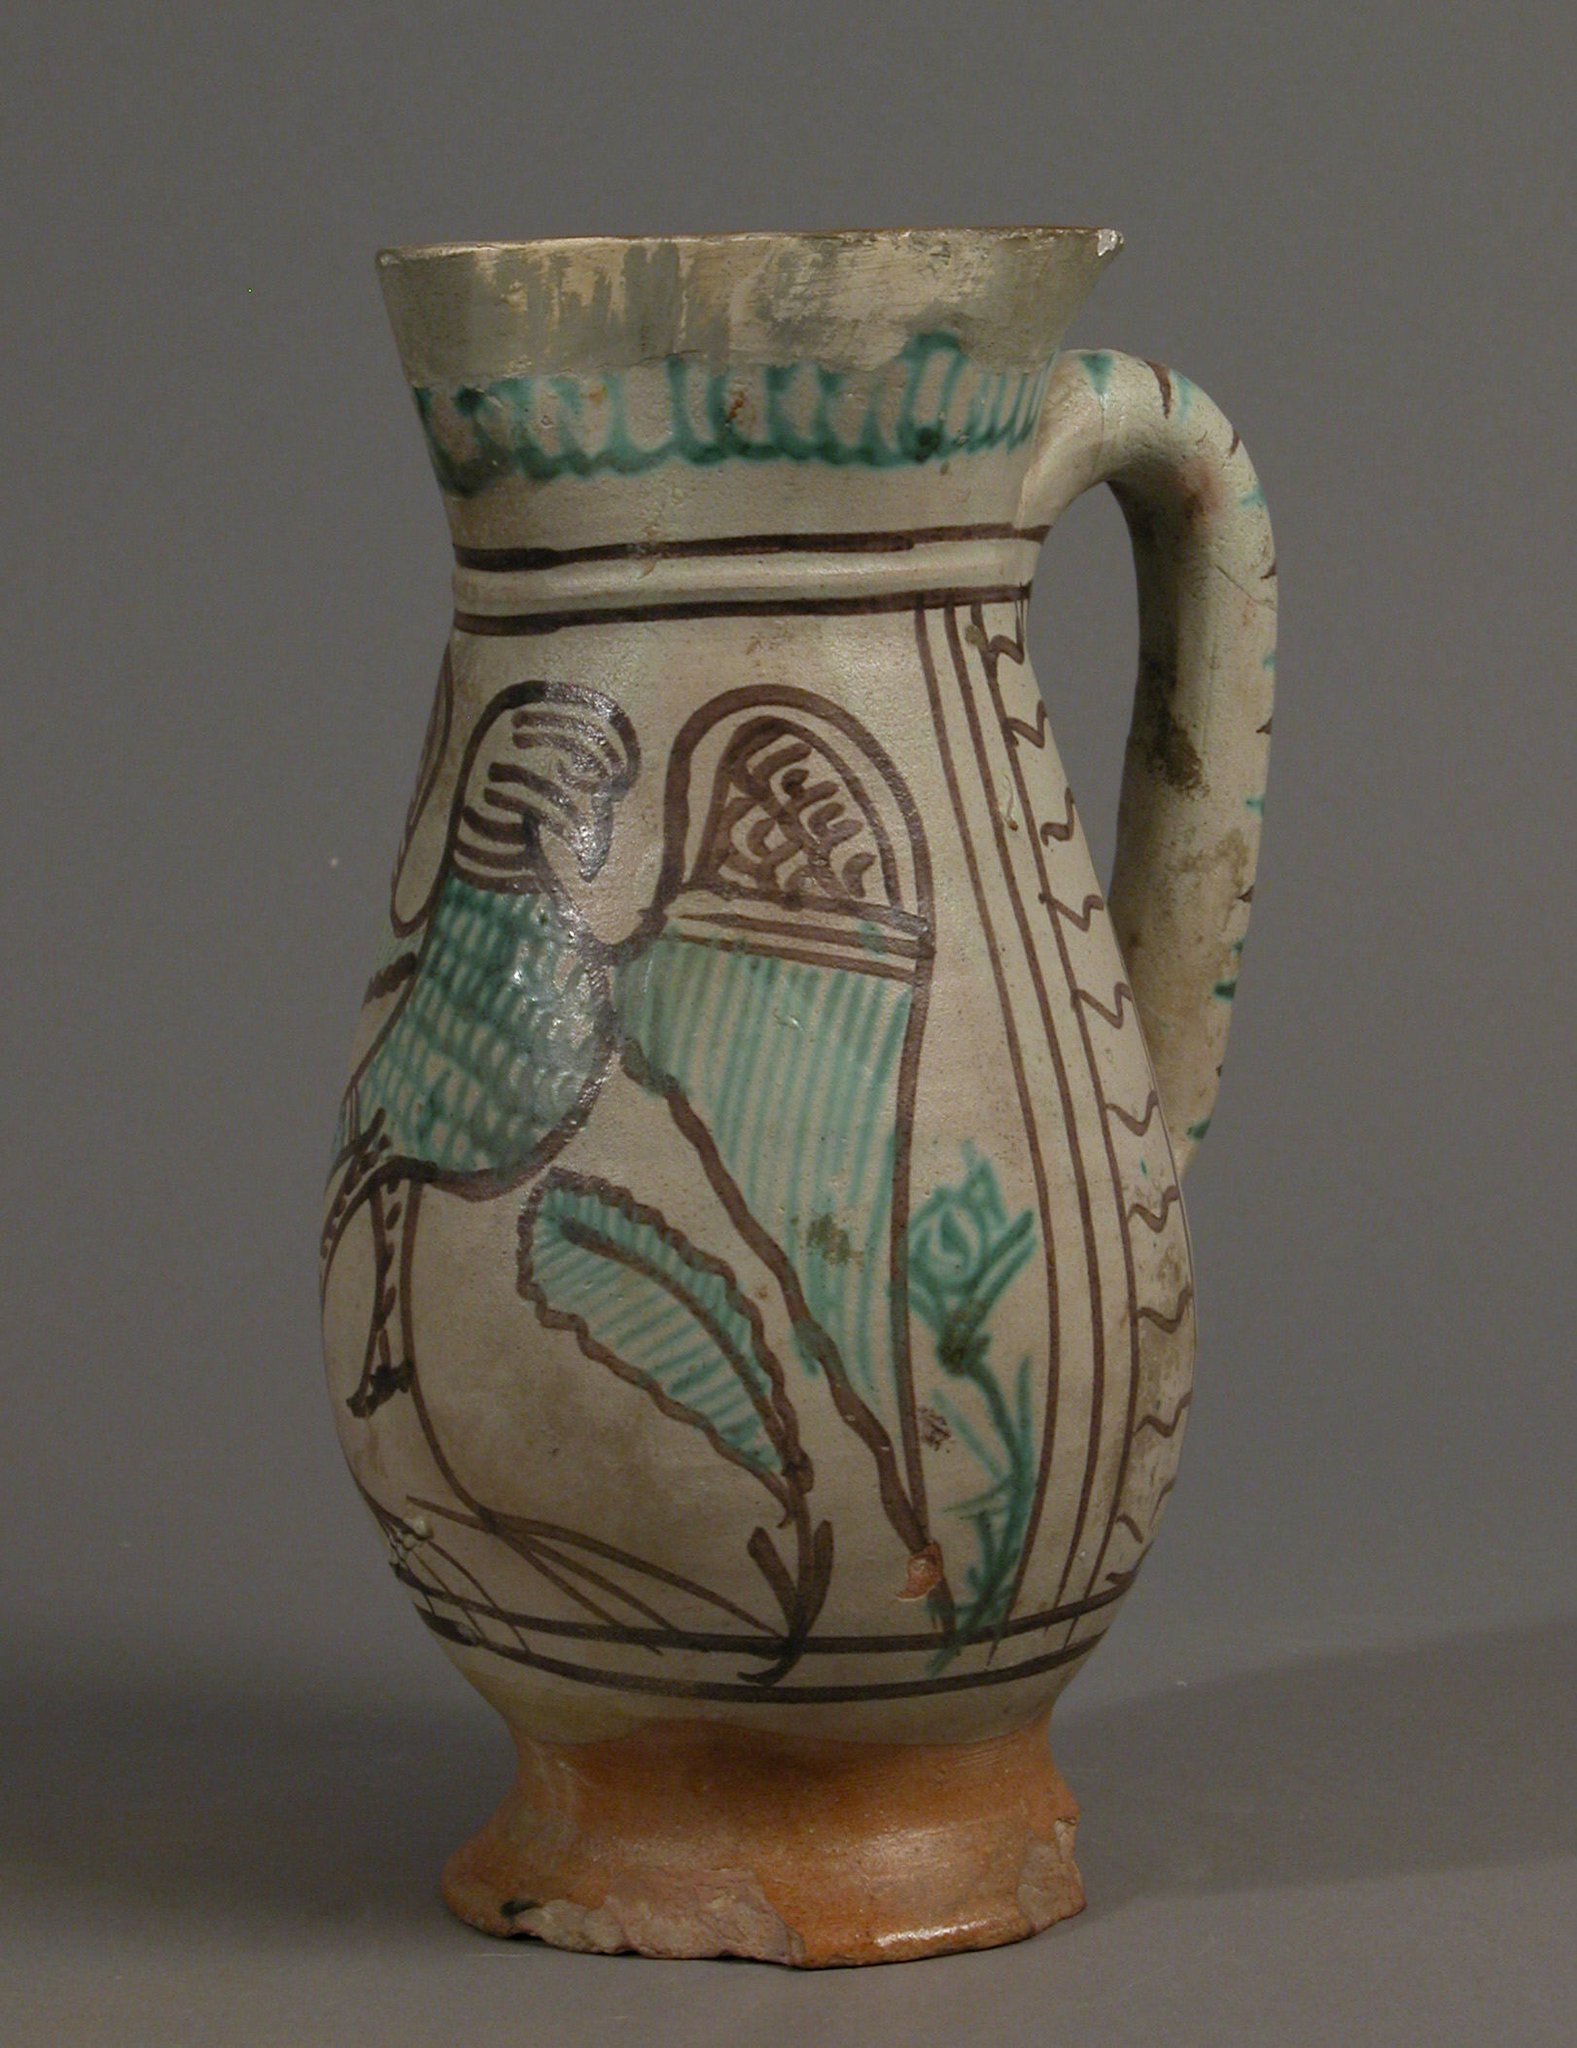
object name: jug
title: Jug with Eagle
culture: italian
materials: earthenware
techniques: glazing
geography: italy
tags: eagles